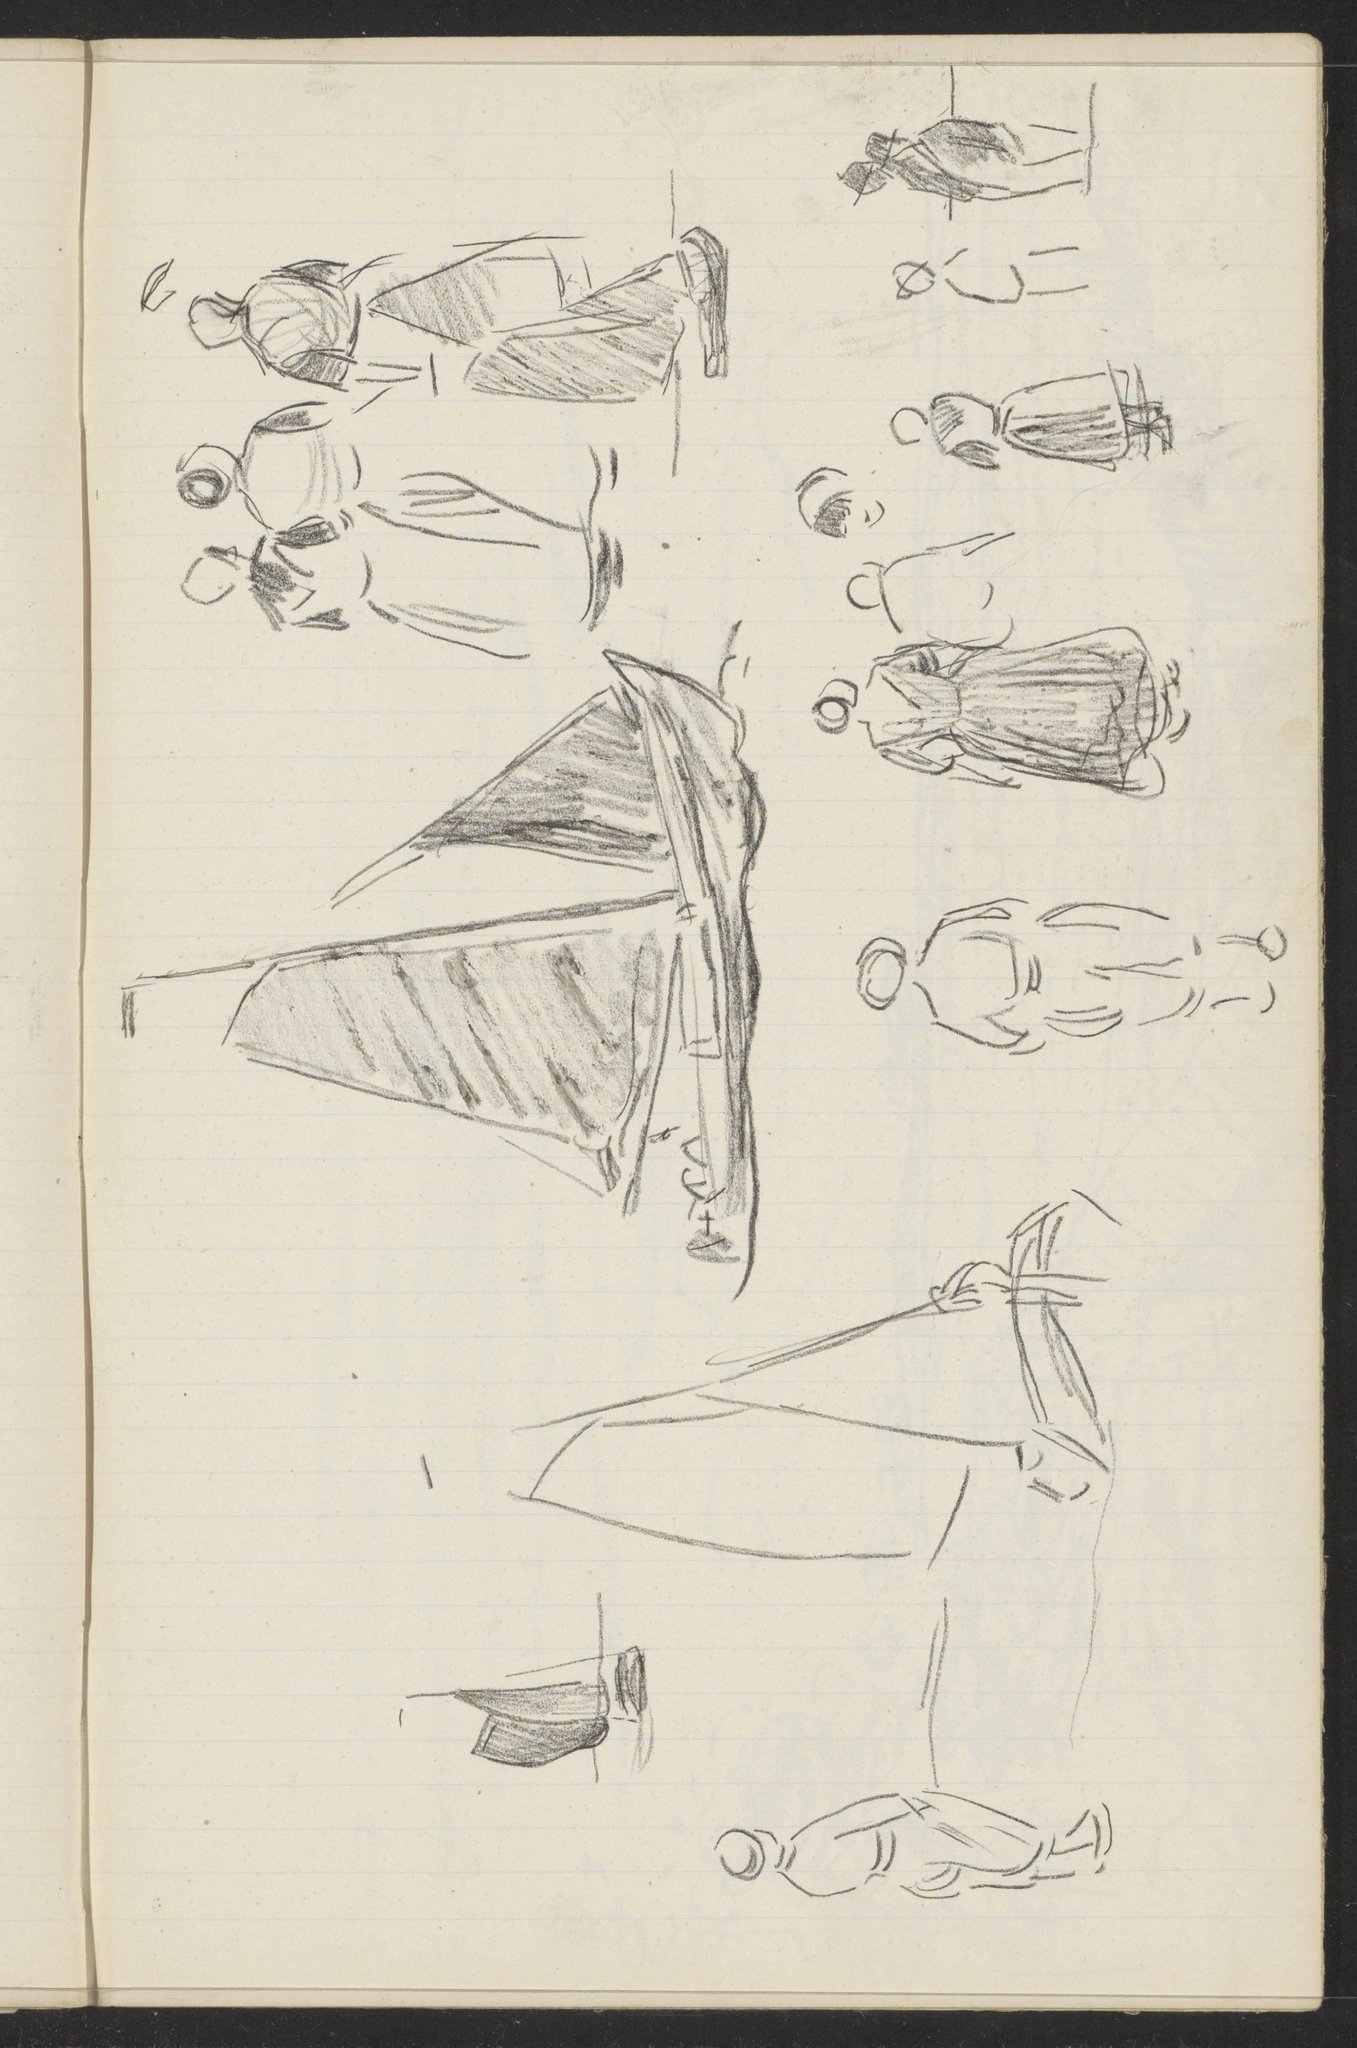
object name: sketchbook leaf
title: Zeilschepen en mannen en vrouwen in werkkleding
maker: willem bastiaan tholen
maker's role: draughtsman, painter, print maker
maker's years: 1860-1931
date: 1900-1931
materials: chalk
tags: adult woman, sailing-ship, sailing-boat, adult man, apron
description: Blad 53 recto uit een schetsboek met 55 bladen.